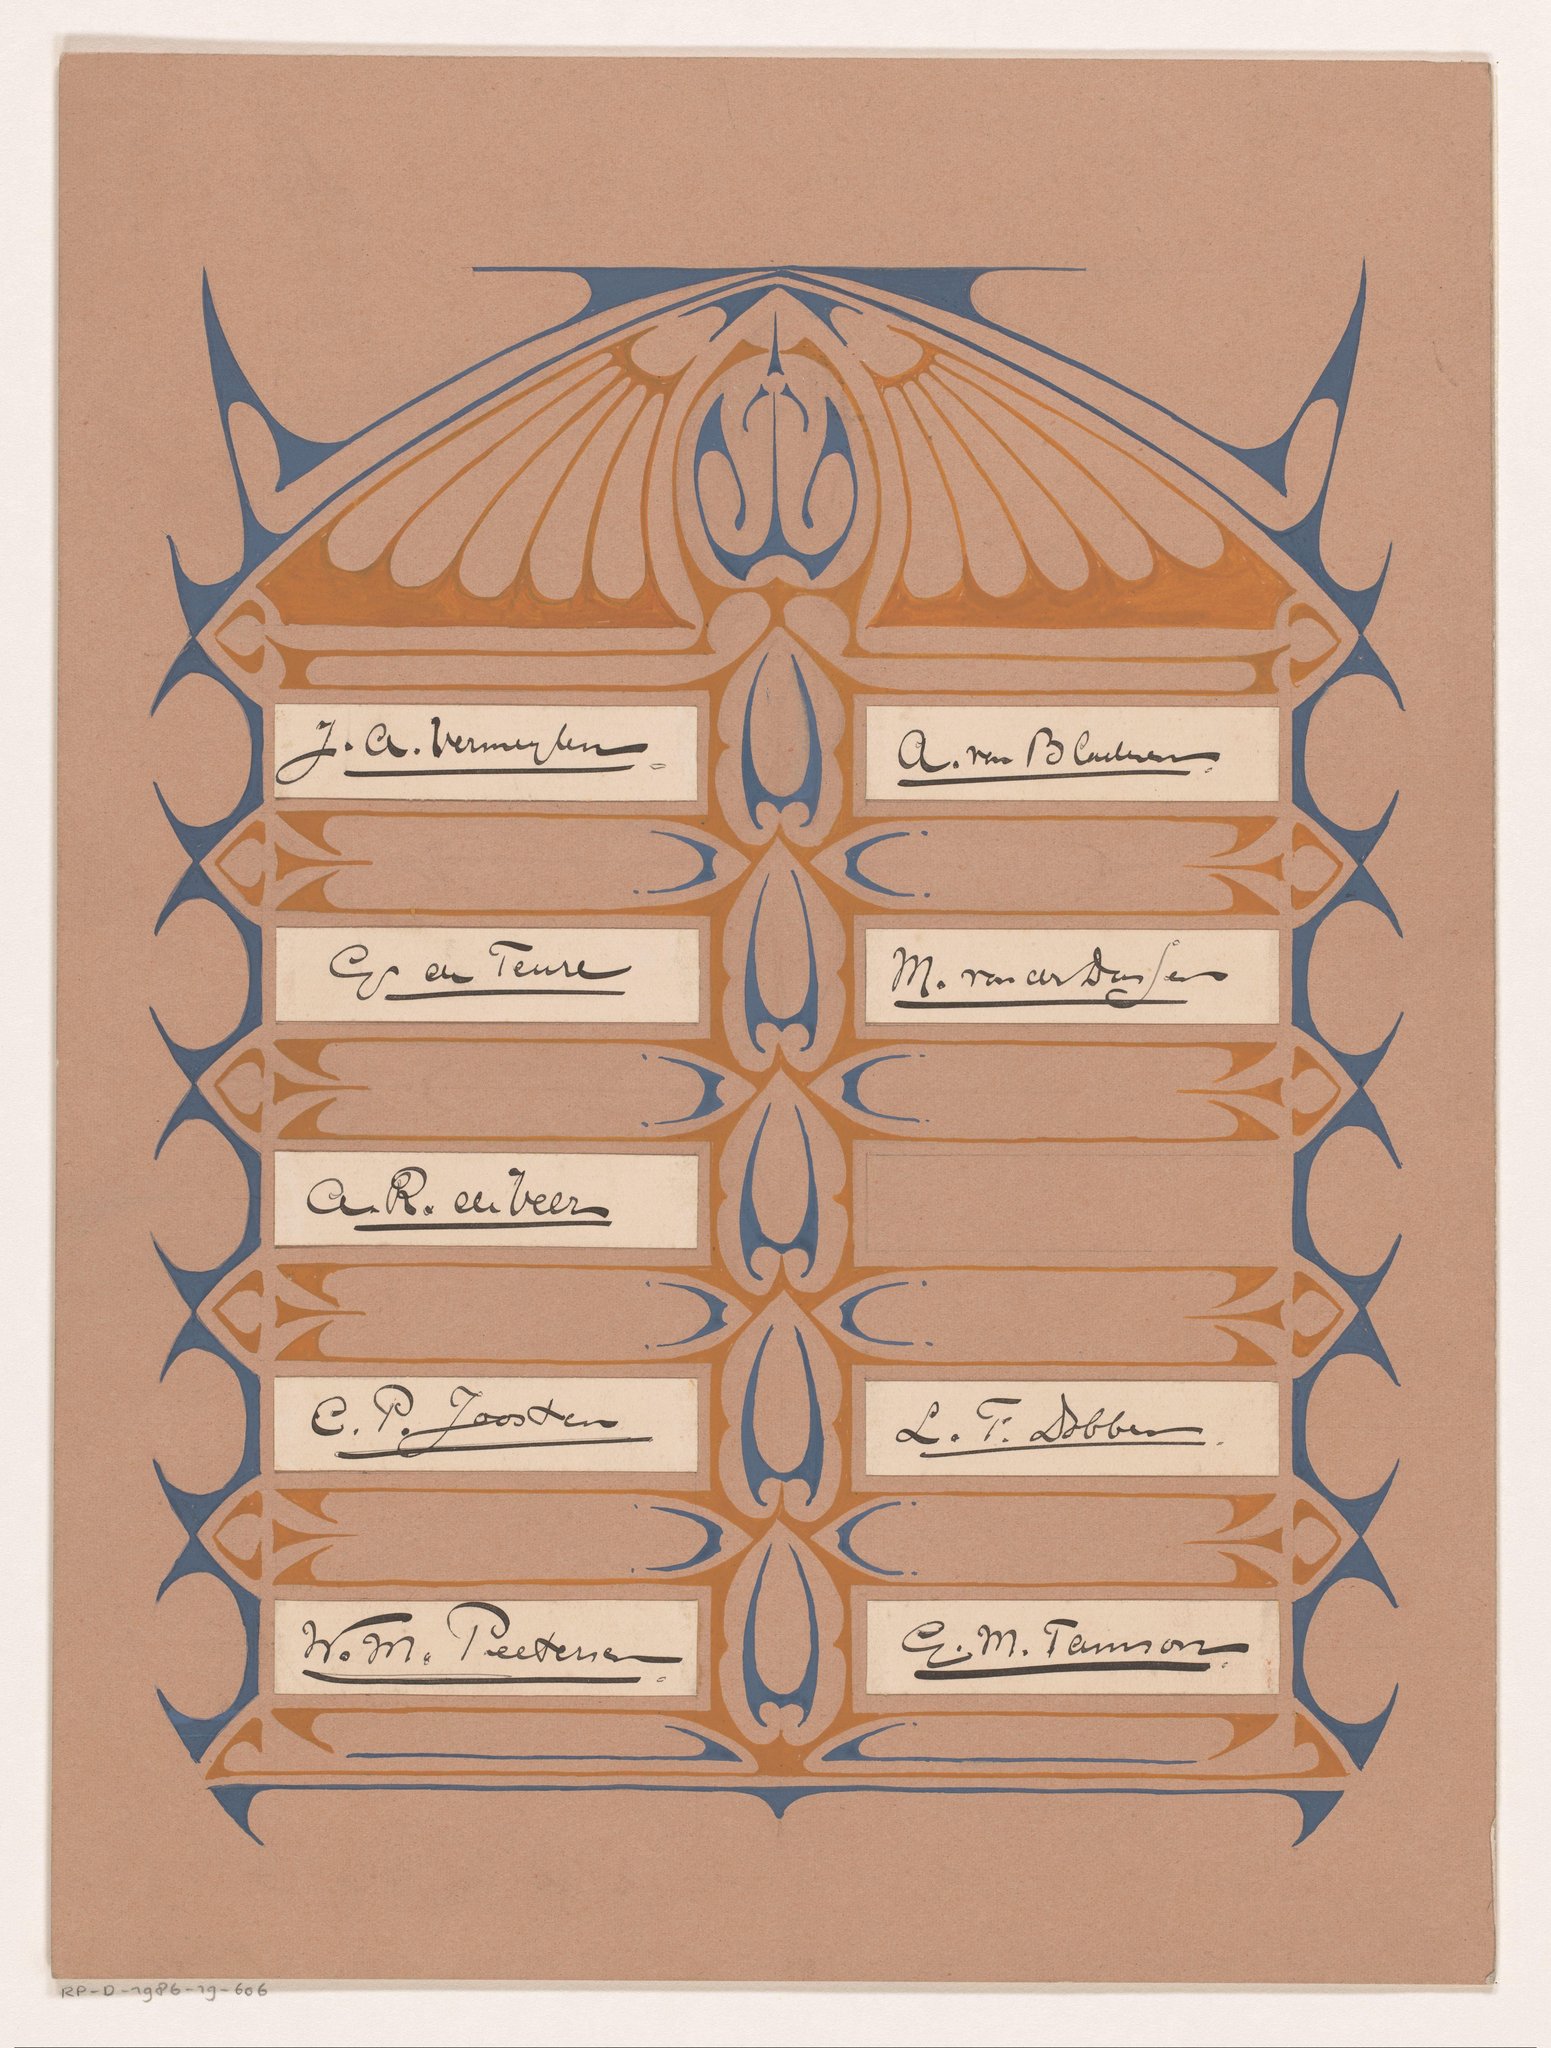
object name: drawing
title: Handtekeningenblad met negen handtekeningen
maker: reinier willem petrus de vries (1874-1953)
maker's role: draughtsman, print maker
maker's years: 1874-1953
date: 1884-1952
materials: cardboard, ink, paint, paper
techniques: brush, pen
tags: ornaments ~ art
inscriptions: collector's mark: ‘R:MVS.’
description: Handtekeningenblad met ornamenten en tien plaatsen voor handtekeningen, waarvan er negen zijn gevuld.